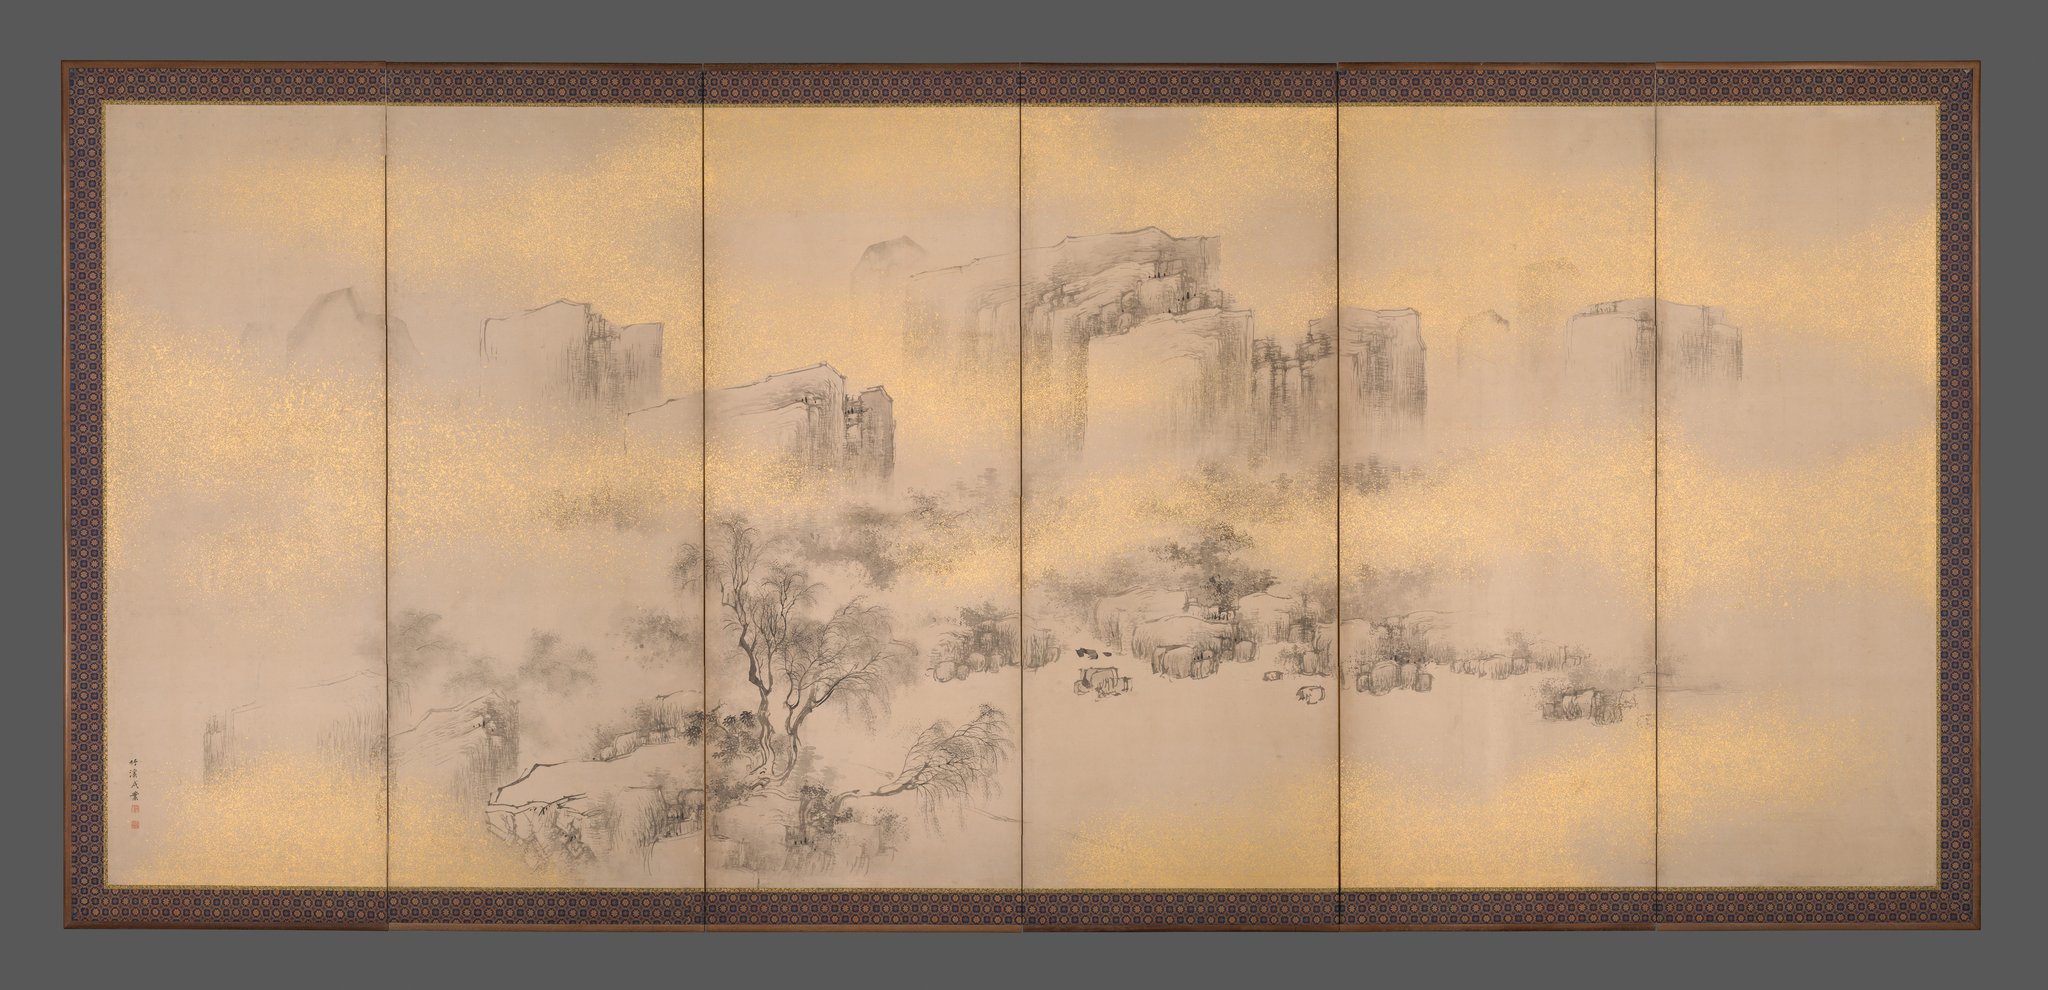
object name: screen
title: Summer and Autumn Landscapes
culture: japanese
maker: nakabayashi chikkei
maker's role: artist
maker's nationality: japanese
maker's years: 1816-1867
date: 1834-1866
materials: gold, ink, panel, paper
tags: mountains,trees